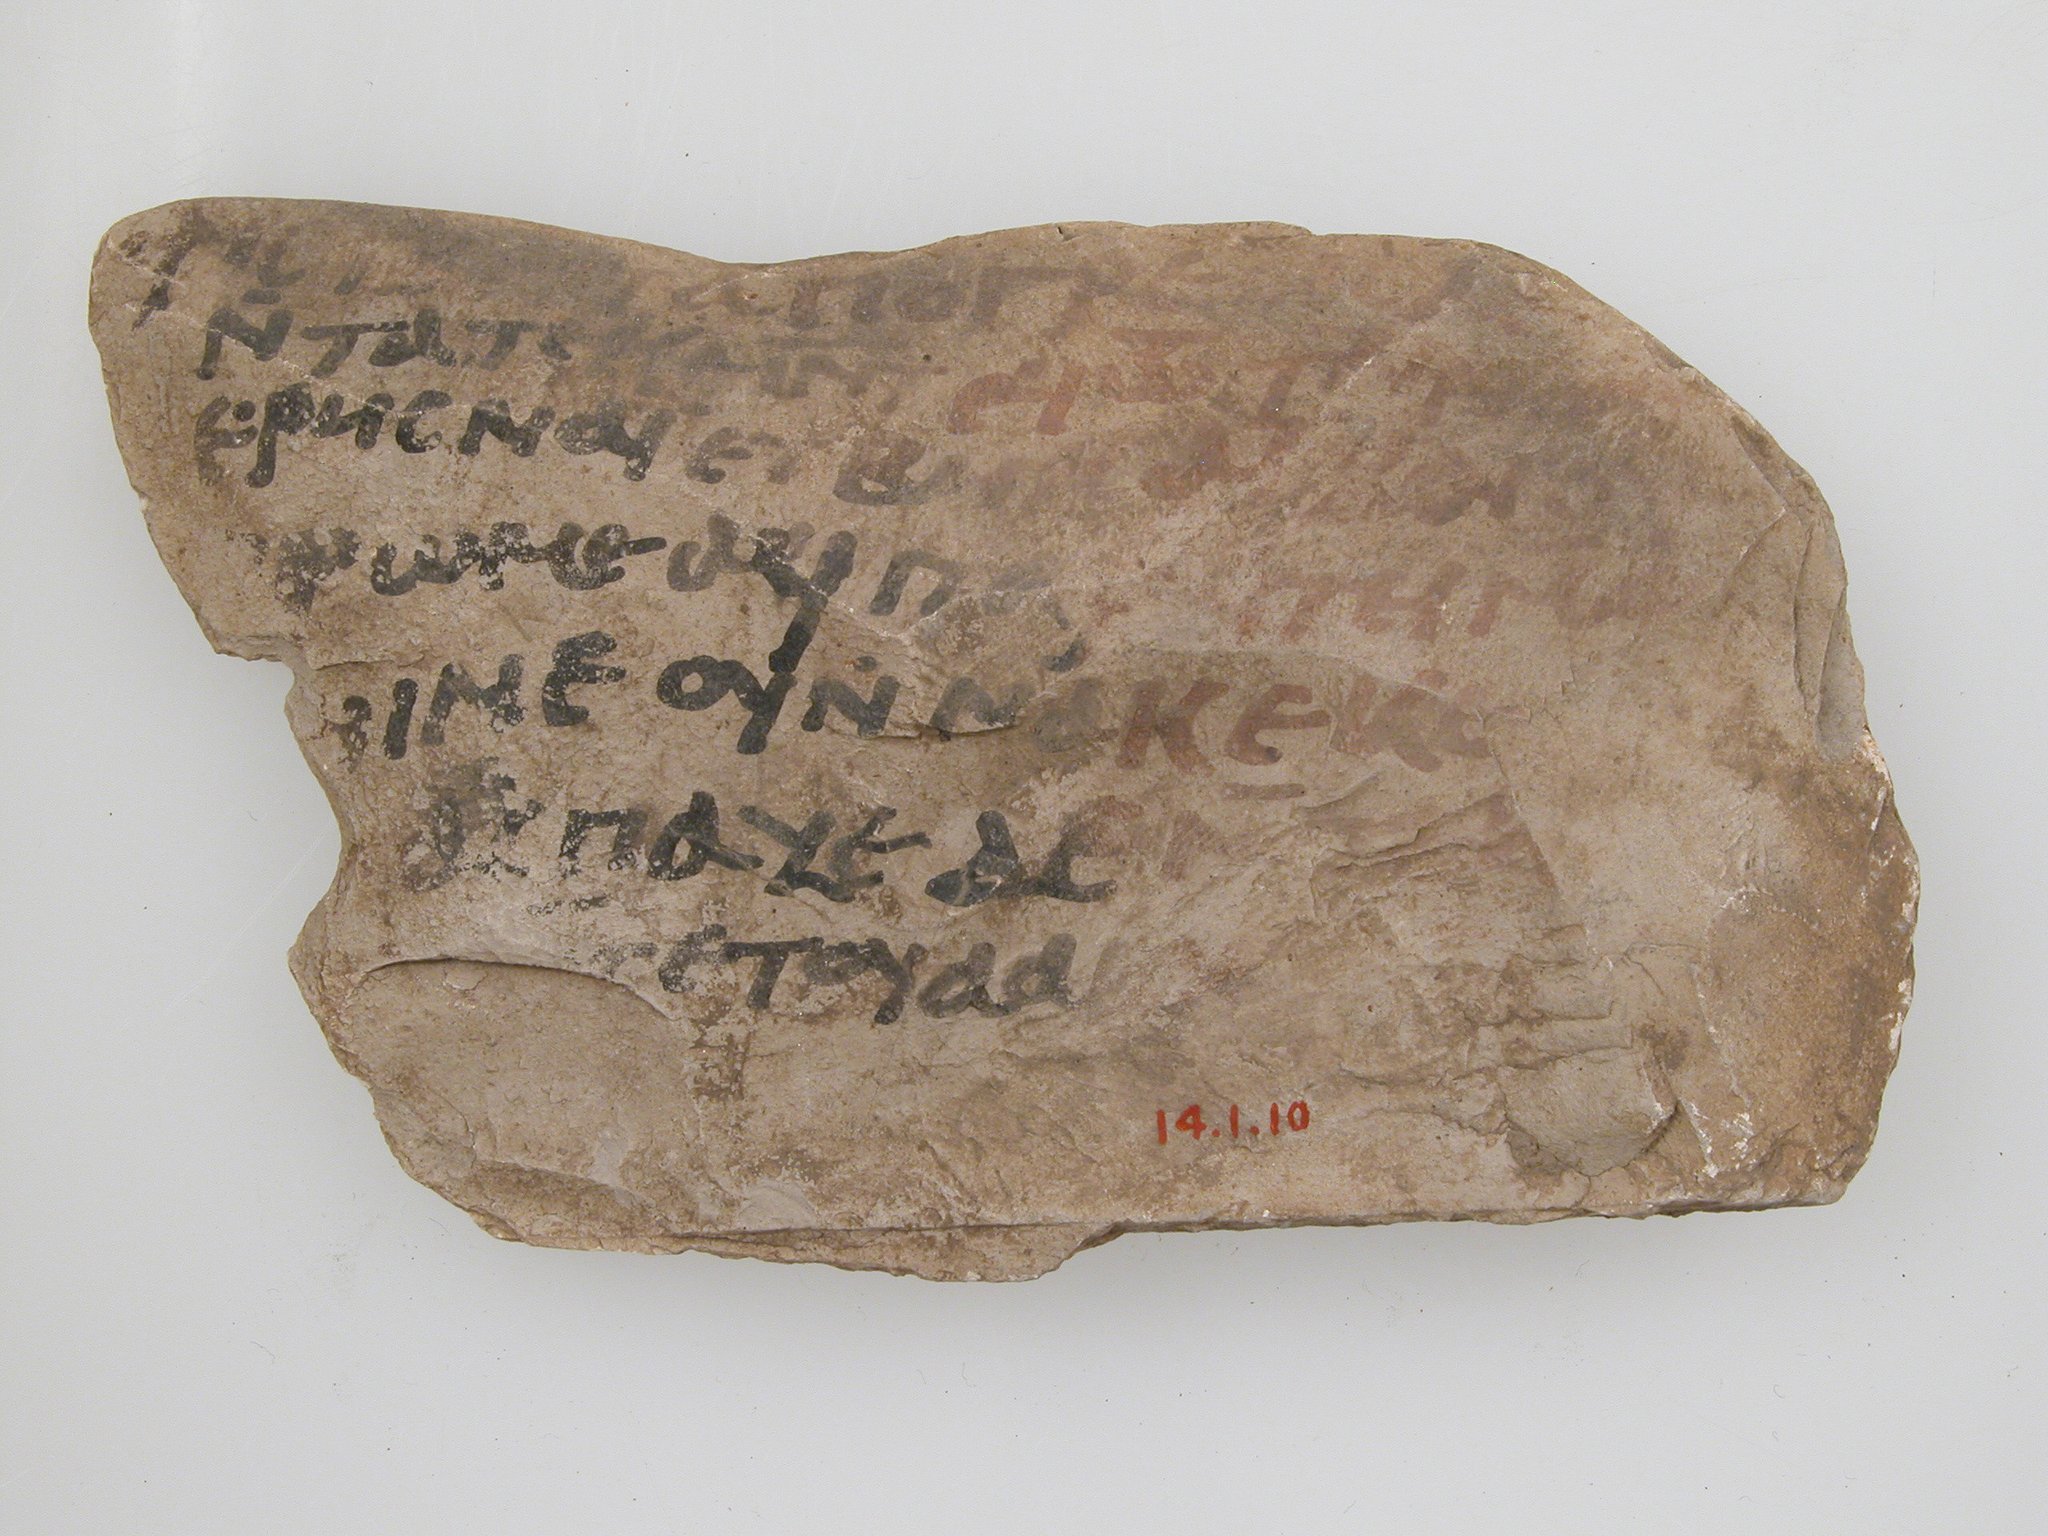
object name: ostrakon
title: Ostrakon with a Letter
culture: coptic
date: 600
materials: ink, limestone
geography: egypt